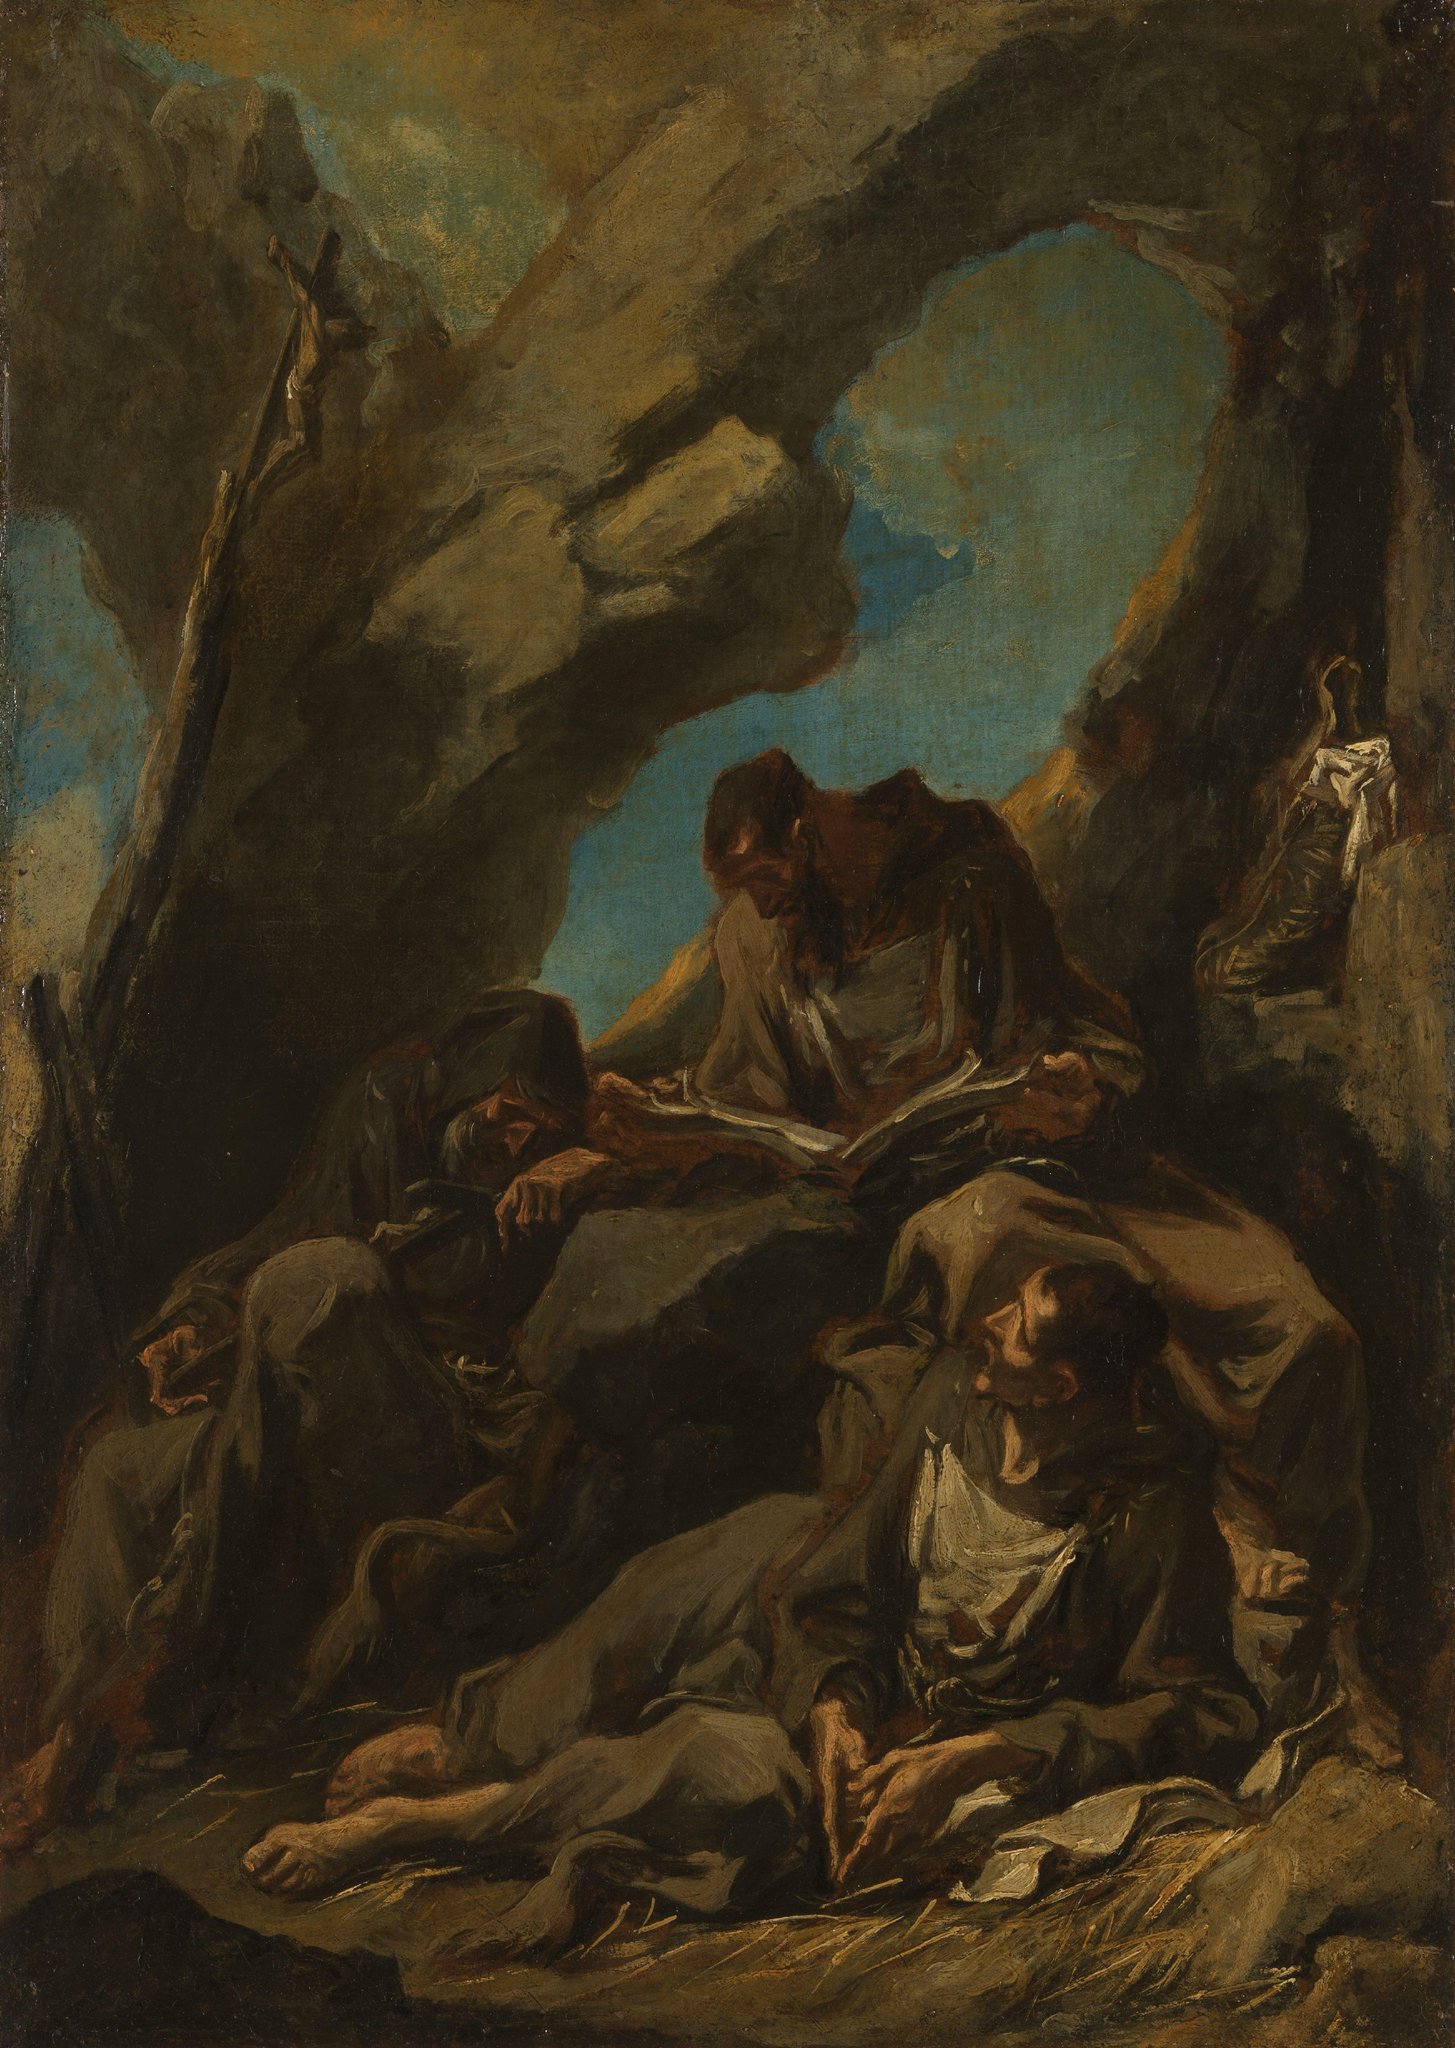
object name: painting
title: Three Camaldolese Monks in Meditative Prayer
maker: alessandro magnasco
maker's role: draughtsman, painter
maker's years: 1657-1749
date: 1710-1740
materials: canvas, oil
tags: monk(s), friar(s), private worship and religious study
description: Drie Capucijner monniken in mediterend gebed, voor een kruisbeeld in een grot. Twee monniken hebben opengeslagen boeken voor zich, de derde koestert een crucifix. Pendant van SK-C-1358.